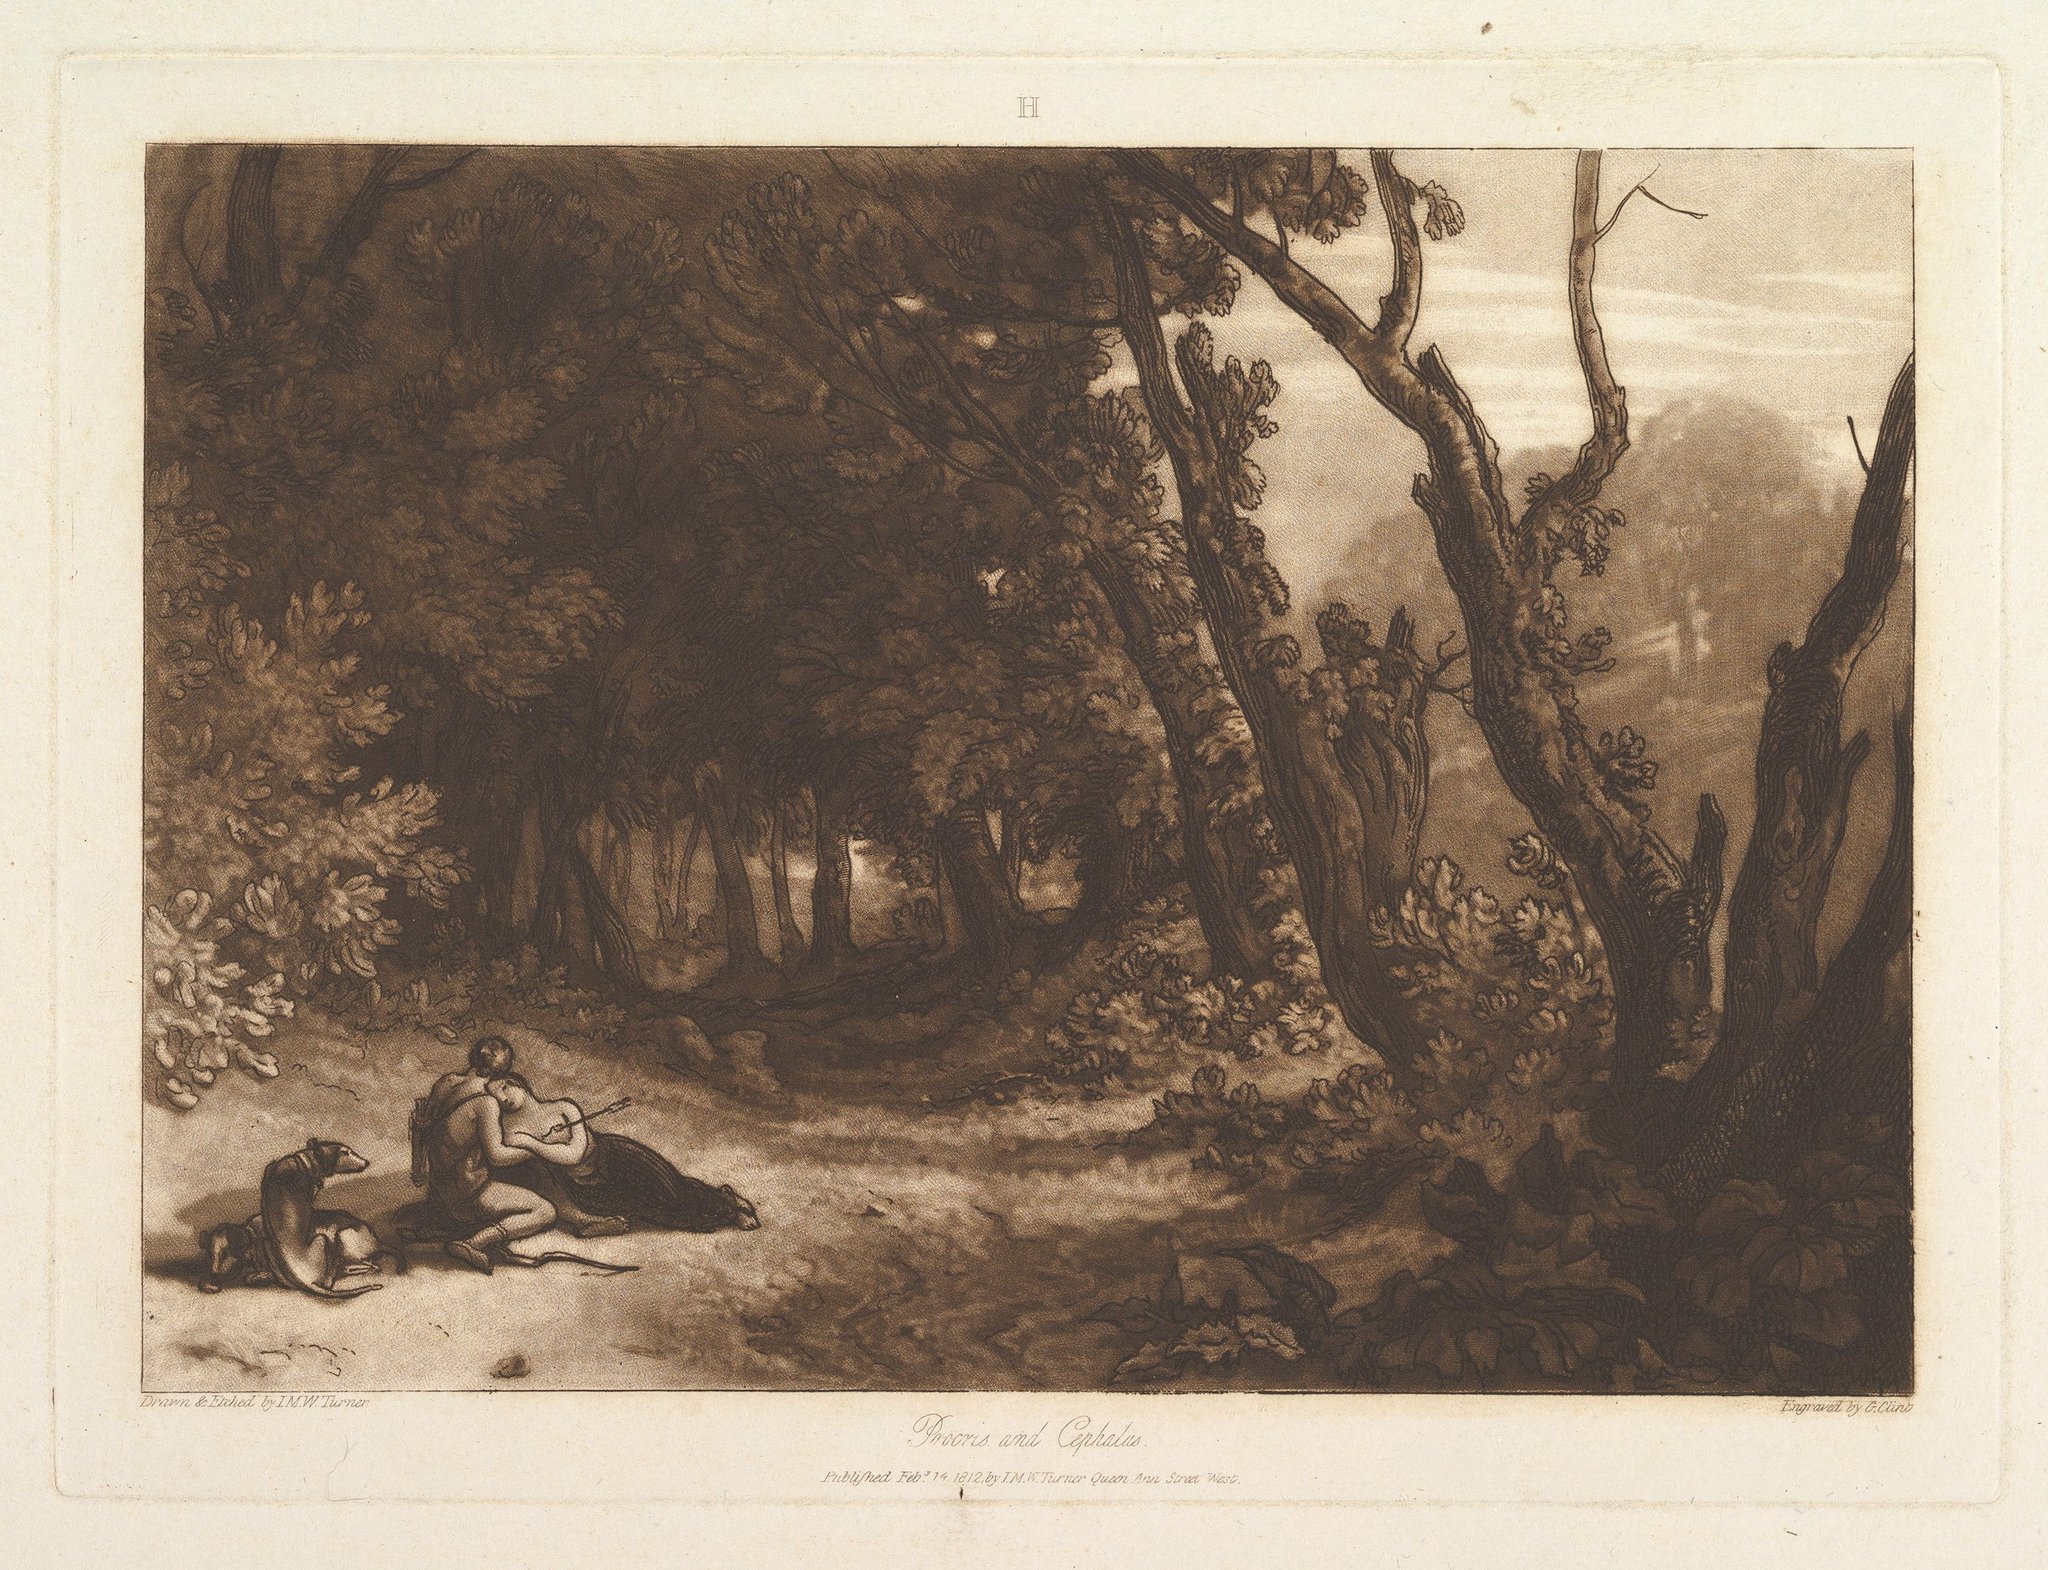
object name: print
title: Procris and Cephalus, part ViII, plate 41 from "Liber Studiorum"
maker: joseph mallord william turner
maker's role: artist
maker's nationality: british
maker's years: 1775-1851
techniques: etching, mezzotint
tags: men,women,dogs,forests